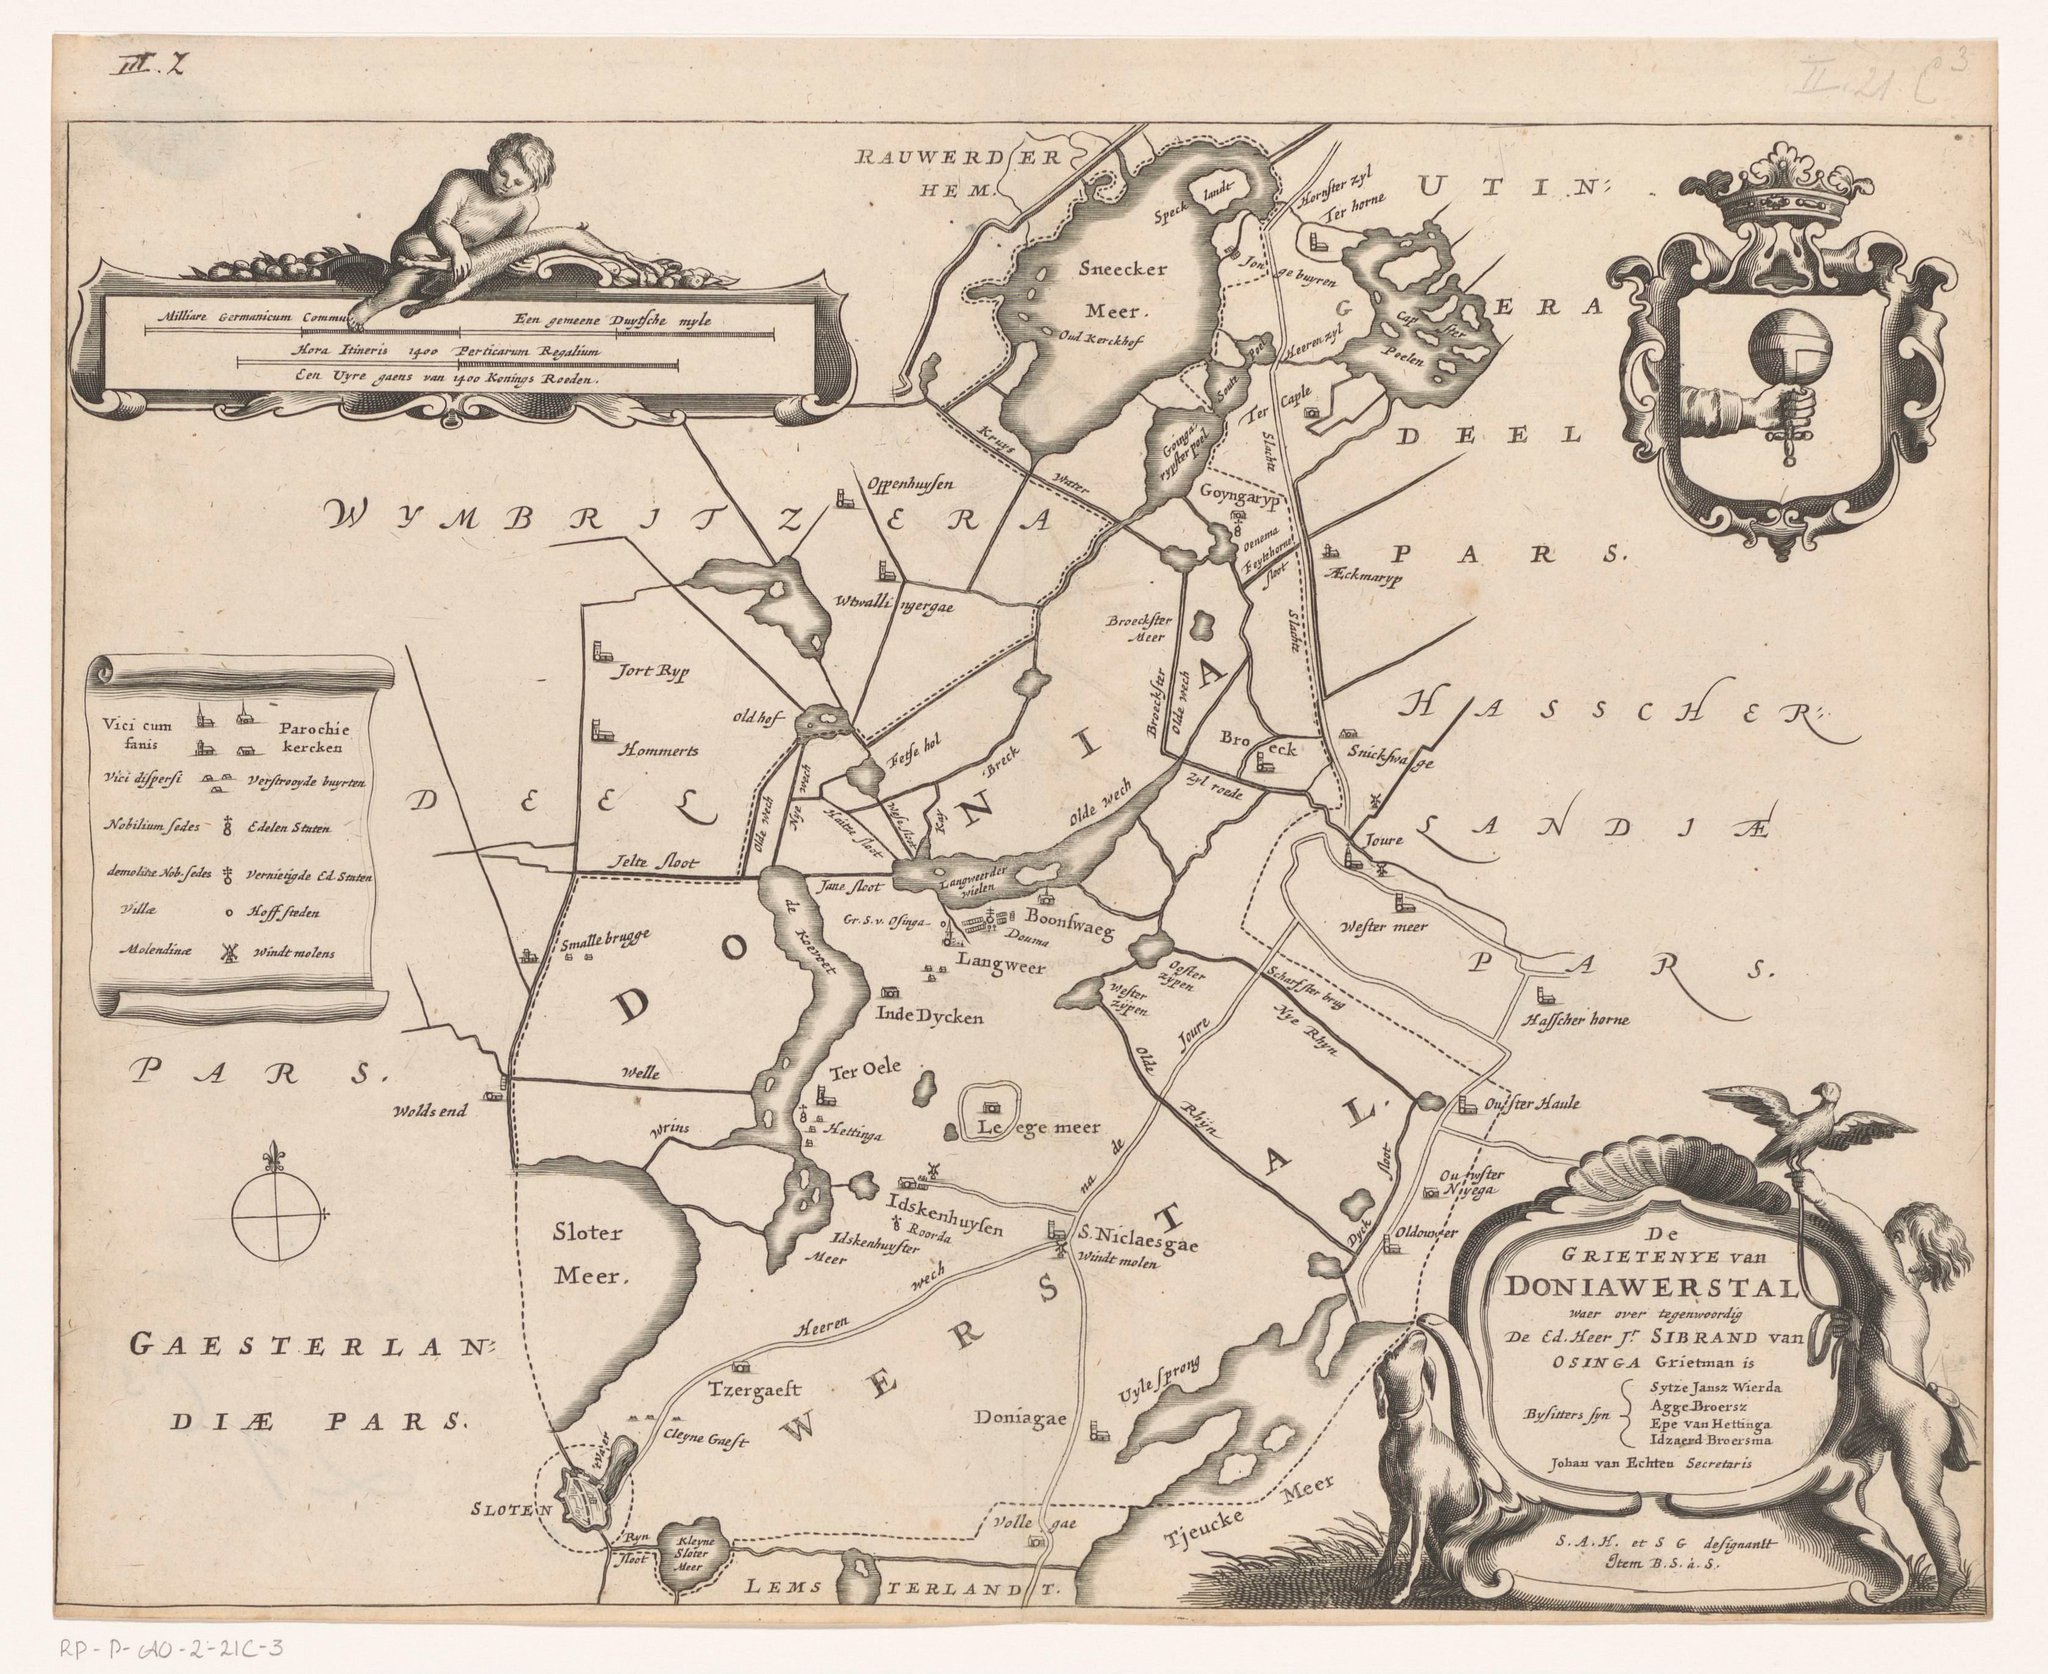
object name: map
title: Kaart van de grietenij Doniawerstal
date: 1664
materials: paper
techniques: engraving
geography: amsterdam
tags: coat of arms (as symbol of the state, etc.), maps of separate countries or regions, hunting, chase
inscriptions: collector's mark: Lugt 2228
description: Linksboven twee schaalstokken: Milliare Germanicum commune / Een gemeene Duytsche myle, Hora itineris 1400 perticarum regalium / Een uyre gaens van 1400 konings roeden. Daaronder legenda. Rechtsboven het wapen van Doniawerstal, rechtsonder cartouche met titel en bestuurlijke informatie over de grietenij. Daaromheen een jongen met een valk en een jachthond.